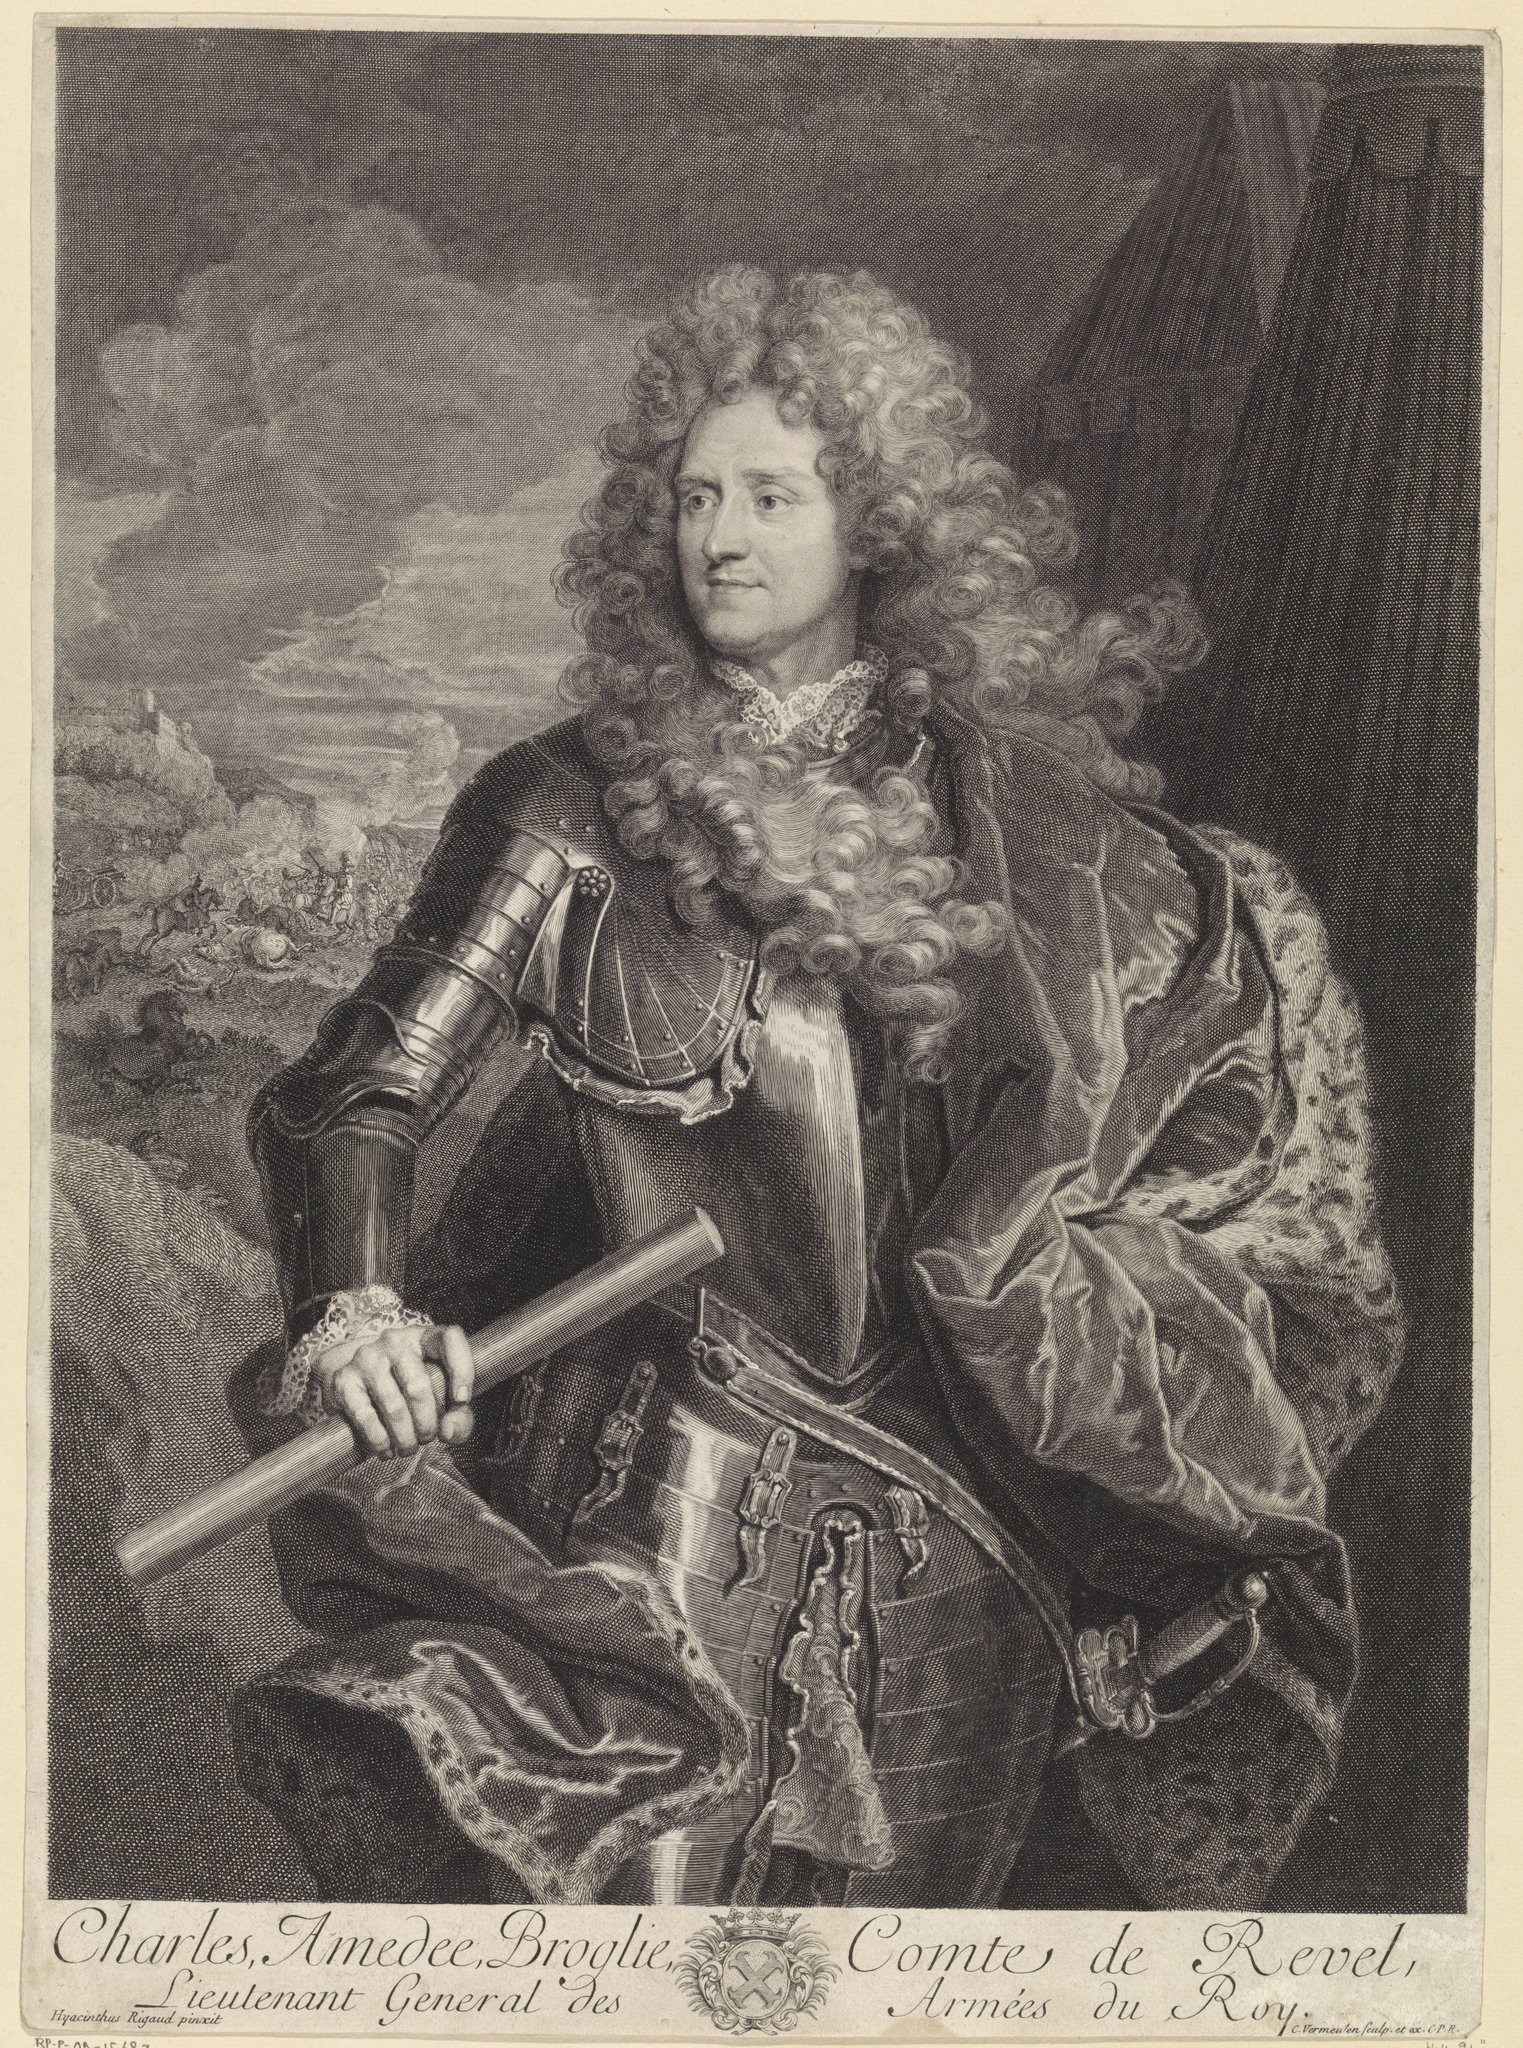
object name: print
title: Portret van Charles-Amédée de Broglie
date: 1680-1709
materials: paper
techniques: engraving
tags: luitenant-generaal, charles-ame´de´e de broglie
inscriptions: collector's mark: Lugt 2228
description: Portret van luitenant-generaal Charles-Amédée de Broglie. In zijn hand een commandostaf en op de achtergrond een veldslag.